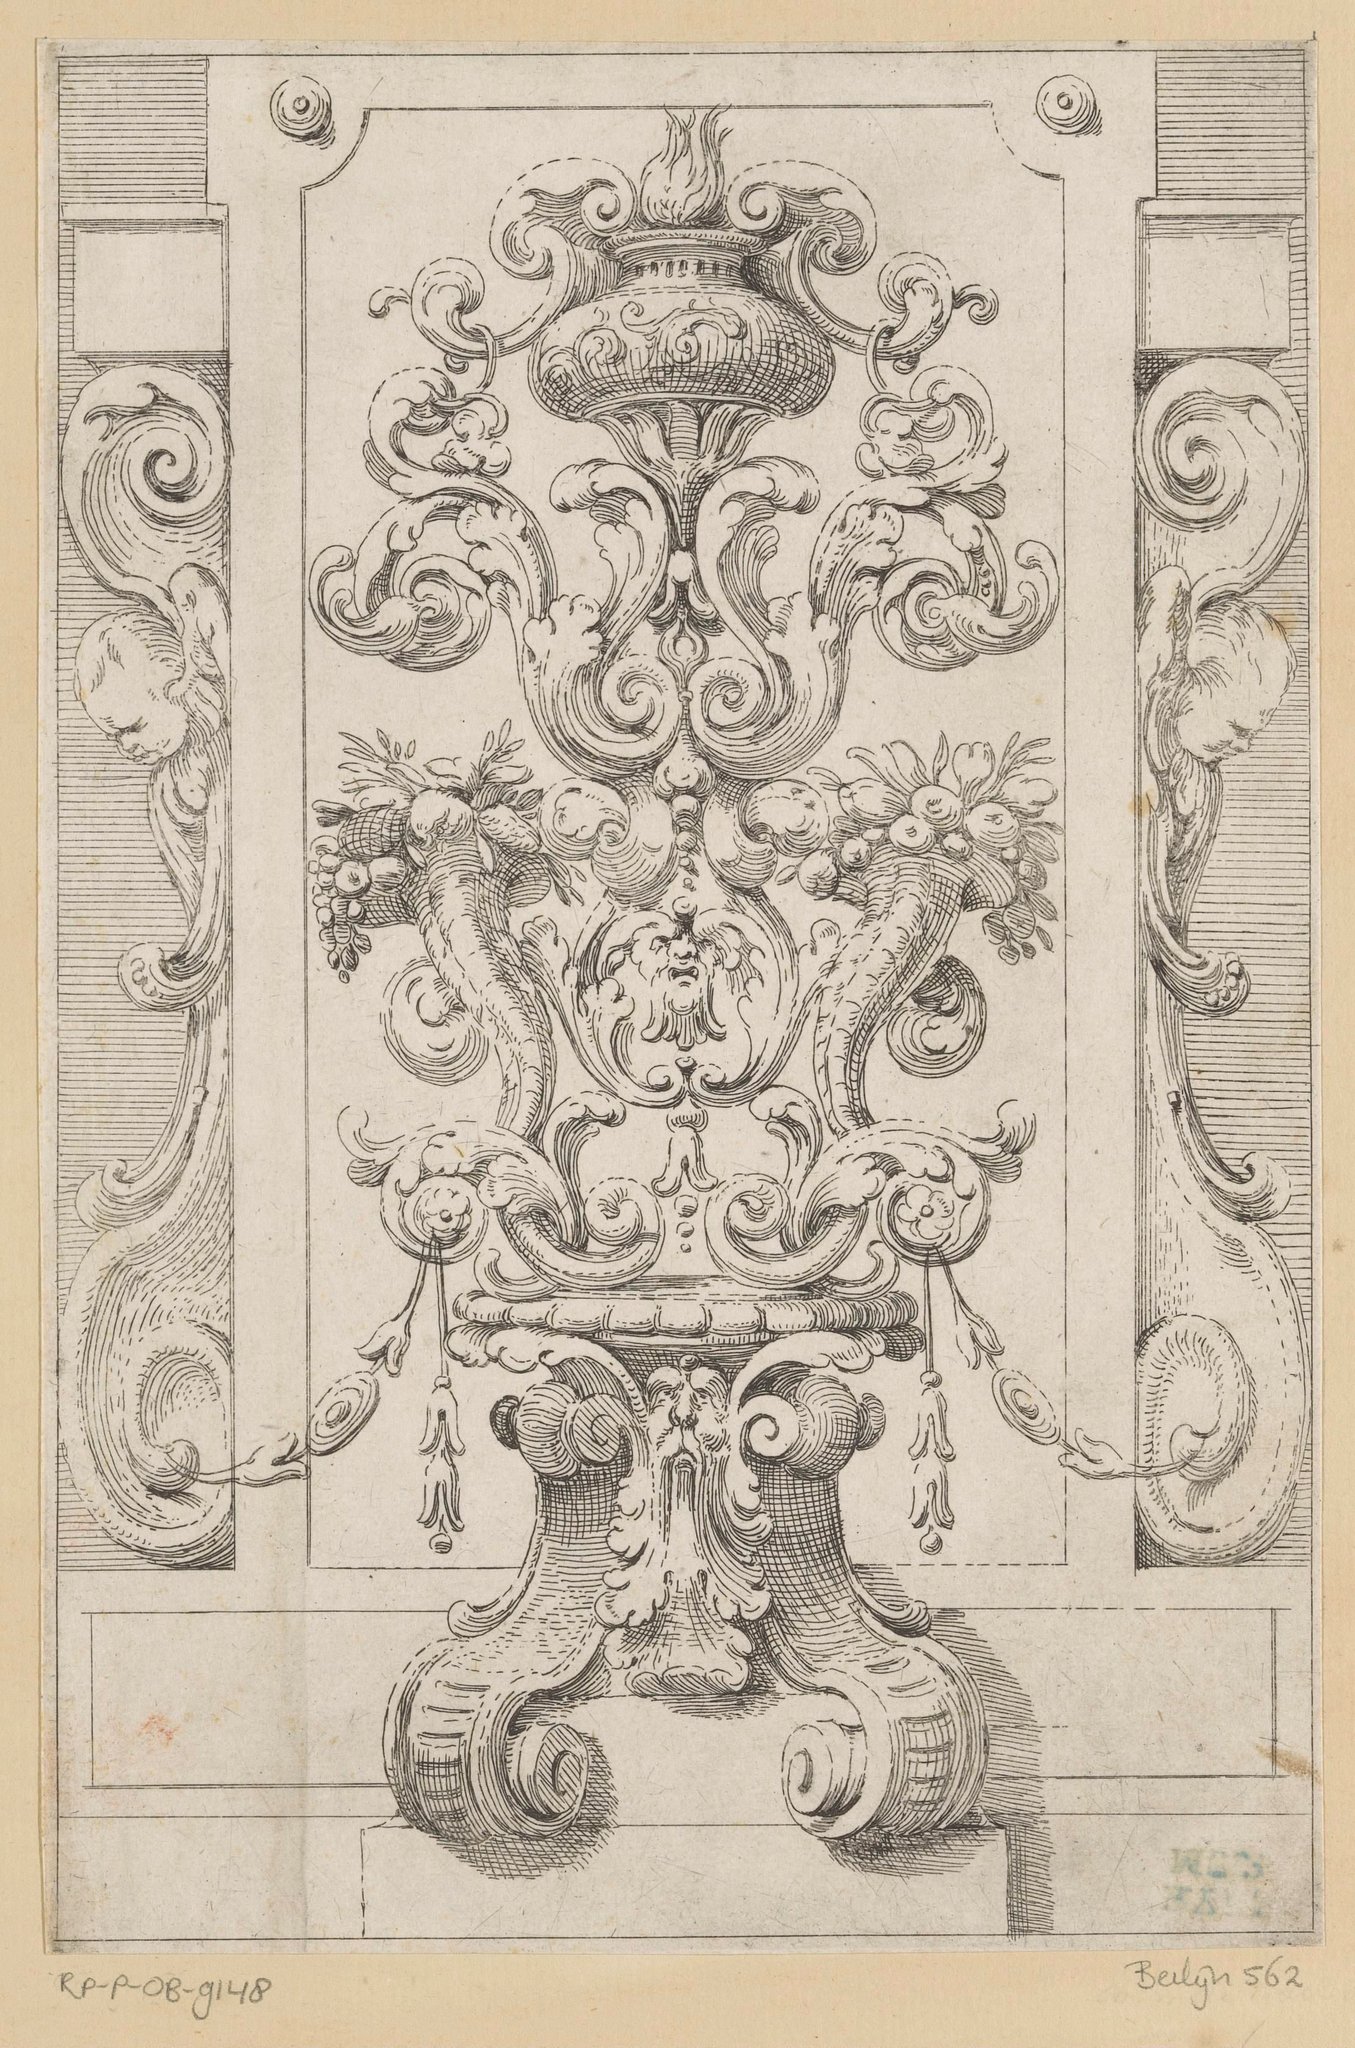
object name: print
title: Wandornament met consoles en hoornen des overvloeds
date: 1636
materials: paper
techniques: etching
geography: italy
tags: cherubs, i.e. children's heads with wings, ornaments ~ art, foliage ~ ornament, other architectural details (console)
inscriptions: collector's mark: Lugt 2165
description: Deze prent maakt deel uit van een reeks van 22 prenten met in totaal 24 cartouches, plus een titelprent.